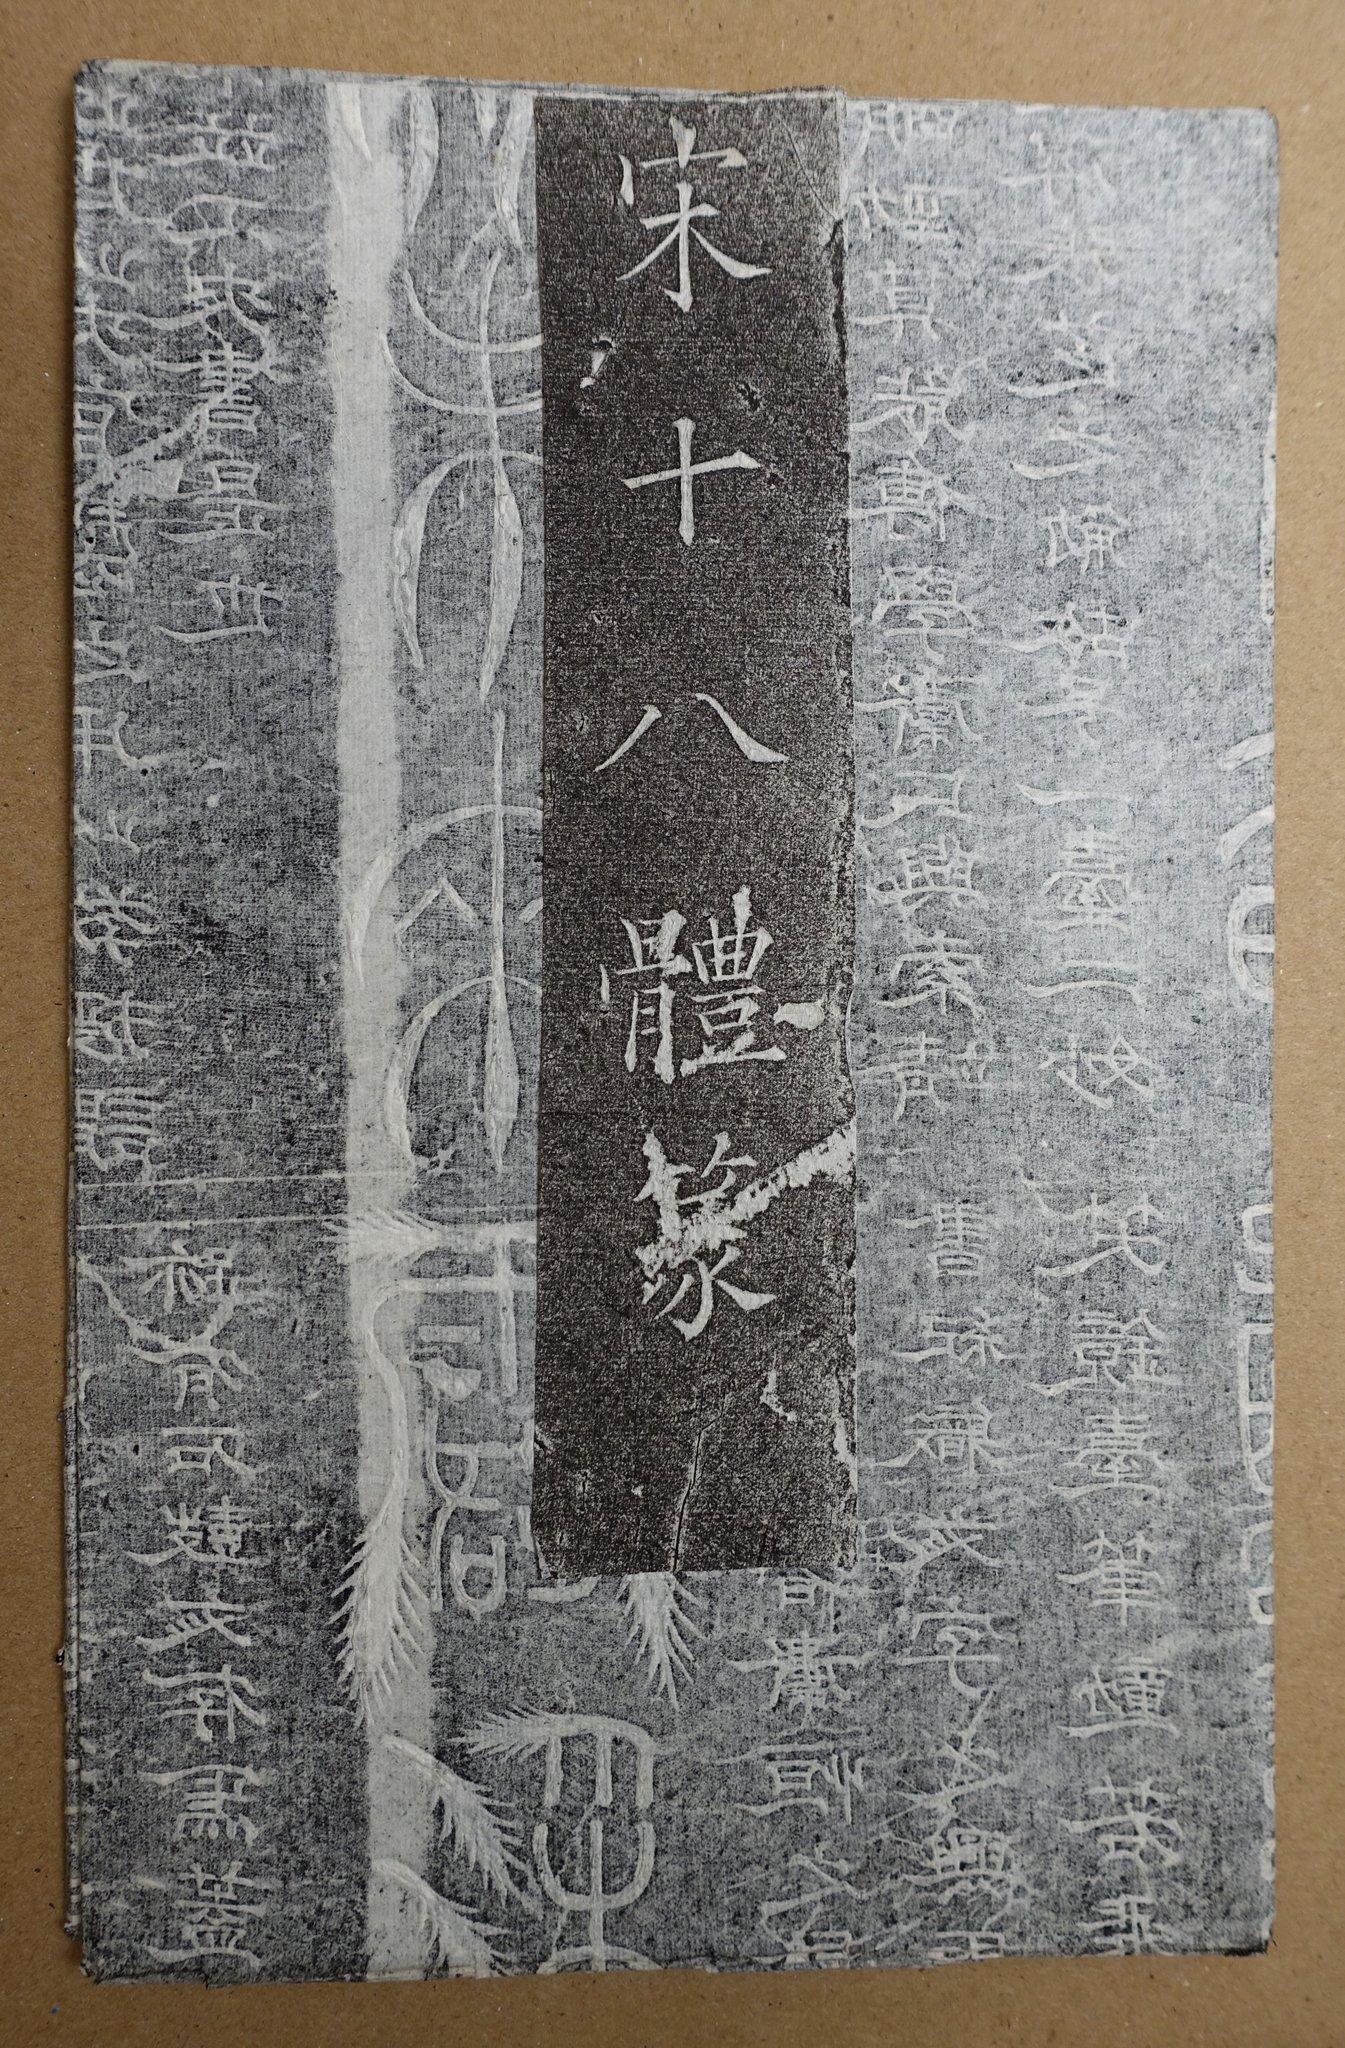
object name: rubbing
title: 18 Styles of Seal Script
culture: chinese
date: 1901-2000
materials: ink, paper